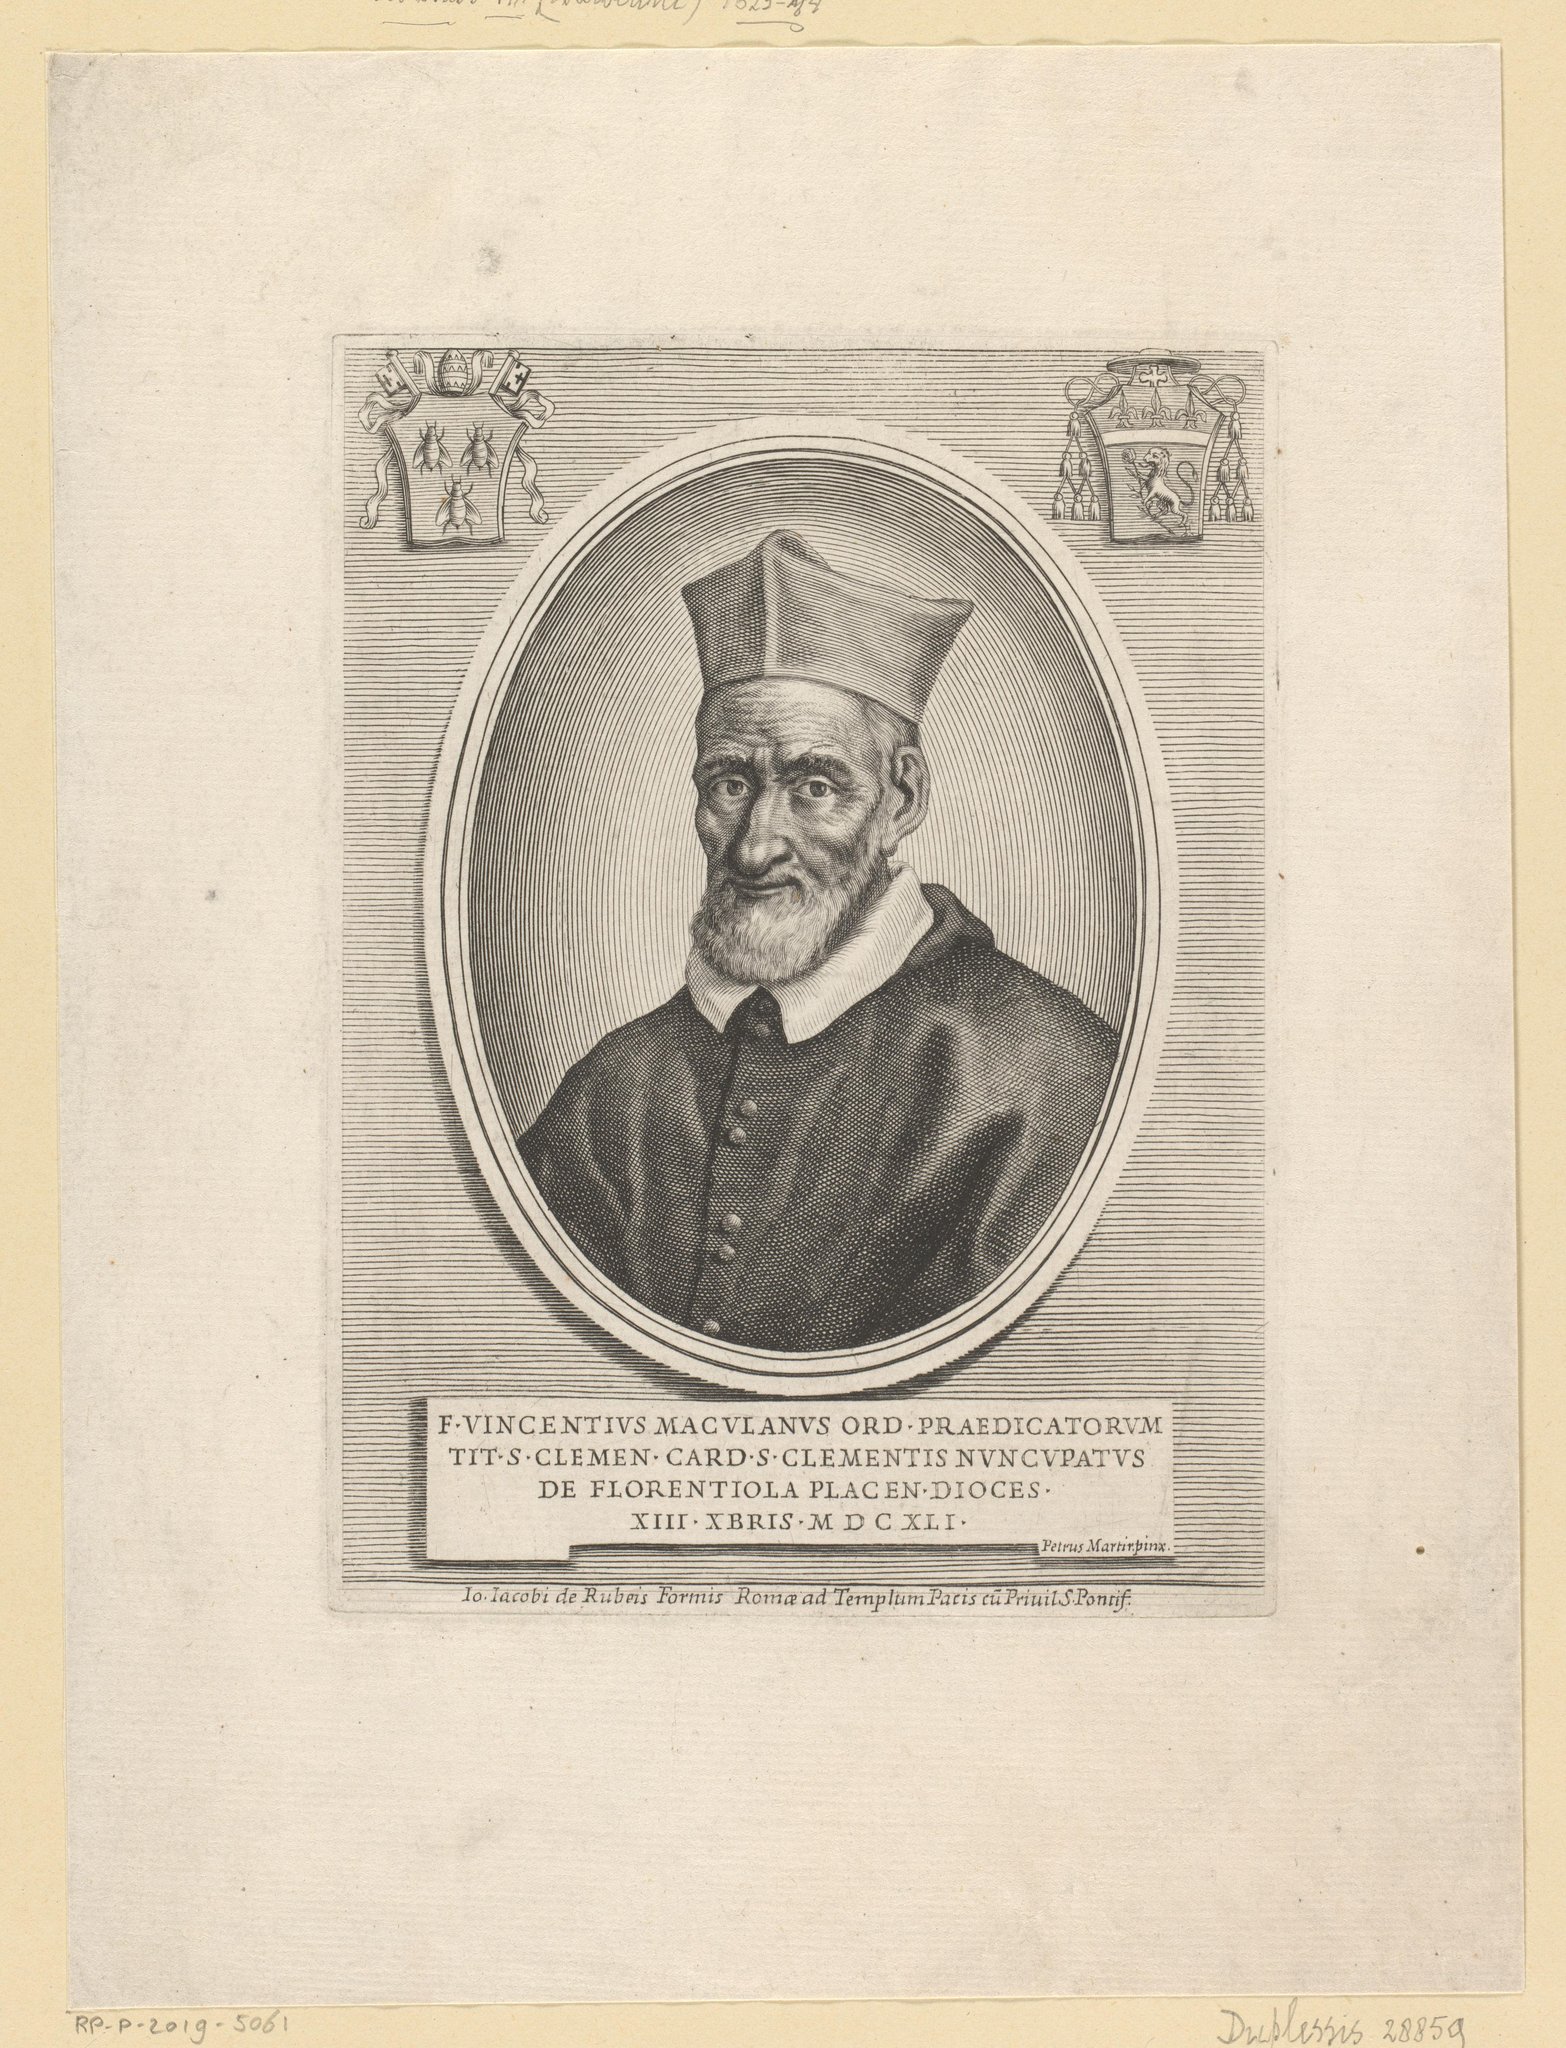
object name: print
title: Portret van kardinaal Vincenzo Maculani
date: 1641-1691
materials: paper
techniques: engraving, etching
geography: rome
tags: rome, cardinal, historical persons, armorial bearing, heraldry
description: Met rechtsboven zijn wapenschild en linksboven het wapen van paus Urbanus VIII.